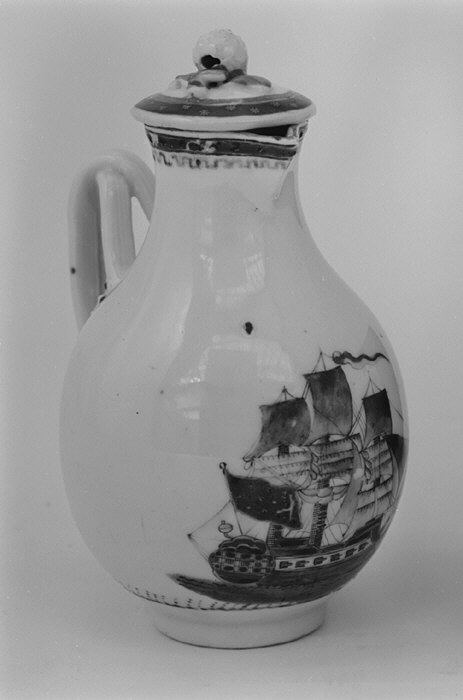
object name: hot milk jug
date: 1767-1800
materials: hard paste porcelain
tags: ships